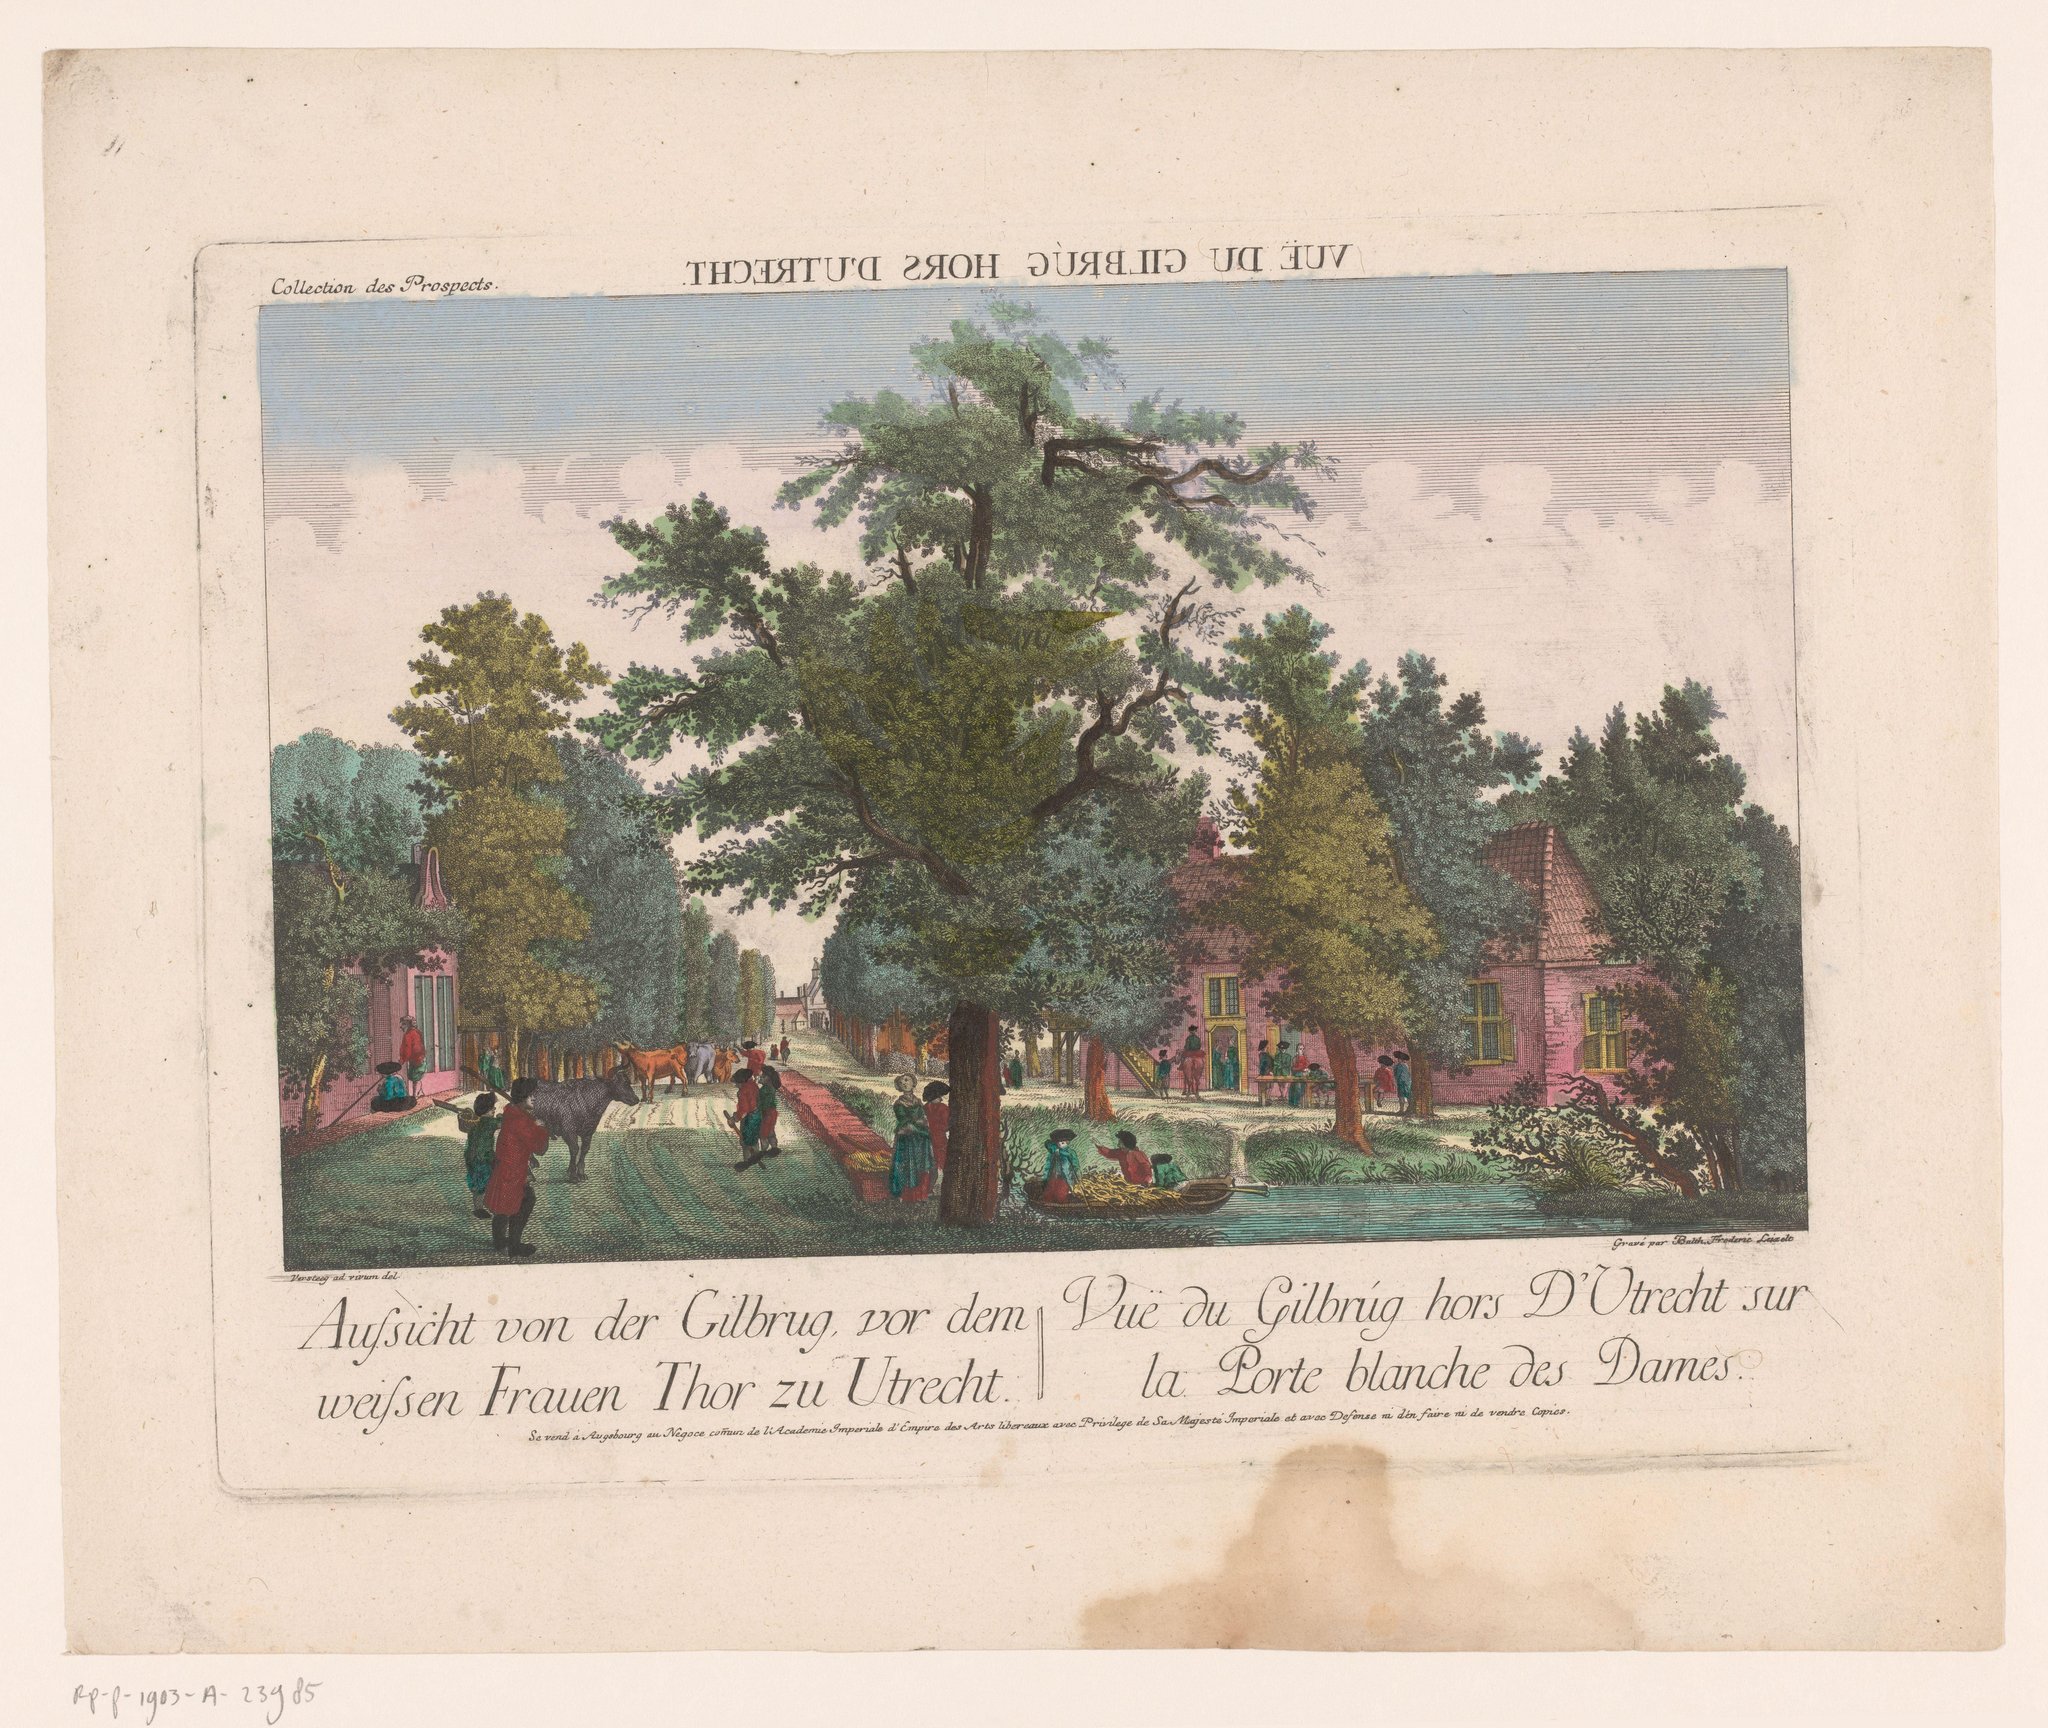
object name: opticaprent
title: Gezicht op Utrecht bij de Wittevrouwenpoort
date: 1755-1779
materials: paper, watercolor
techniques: brush, etching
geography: augsburg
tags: city-view in general; 'veduta', monumental adornments (in city), city-gate, utrecht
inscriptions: collector's mark: Lugt 2228